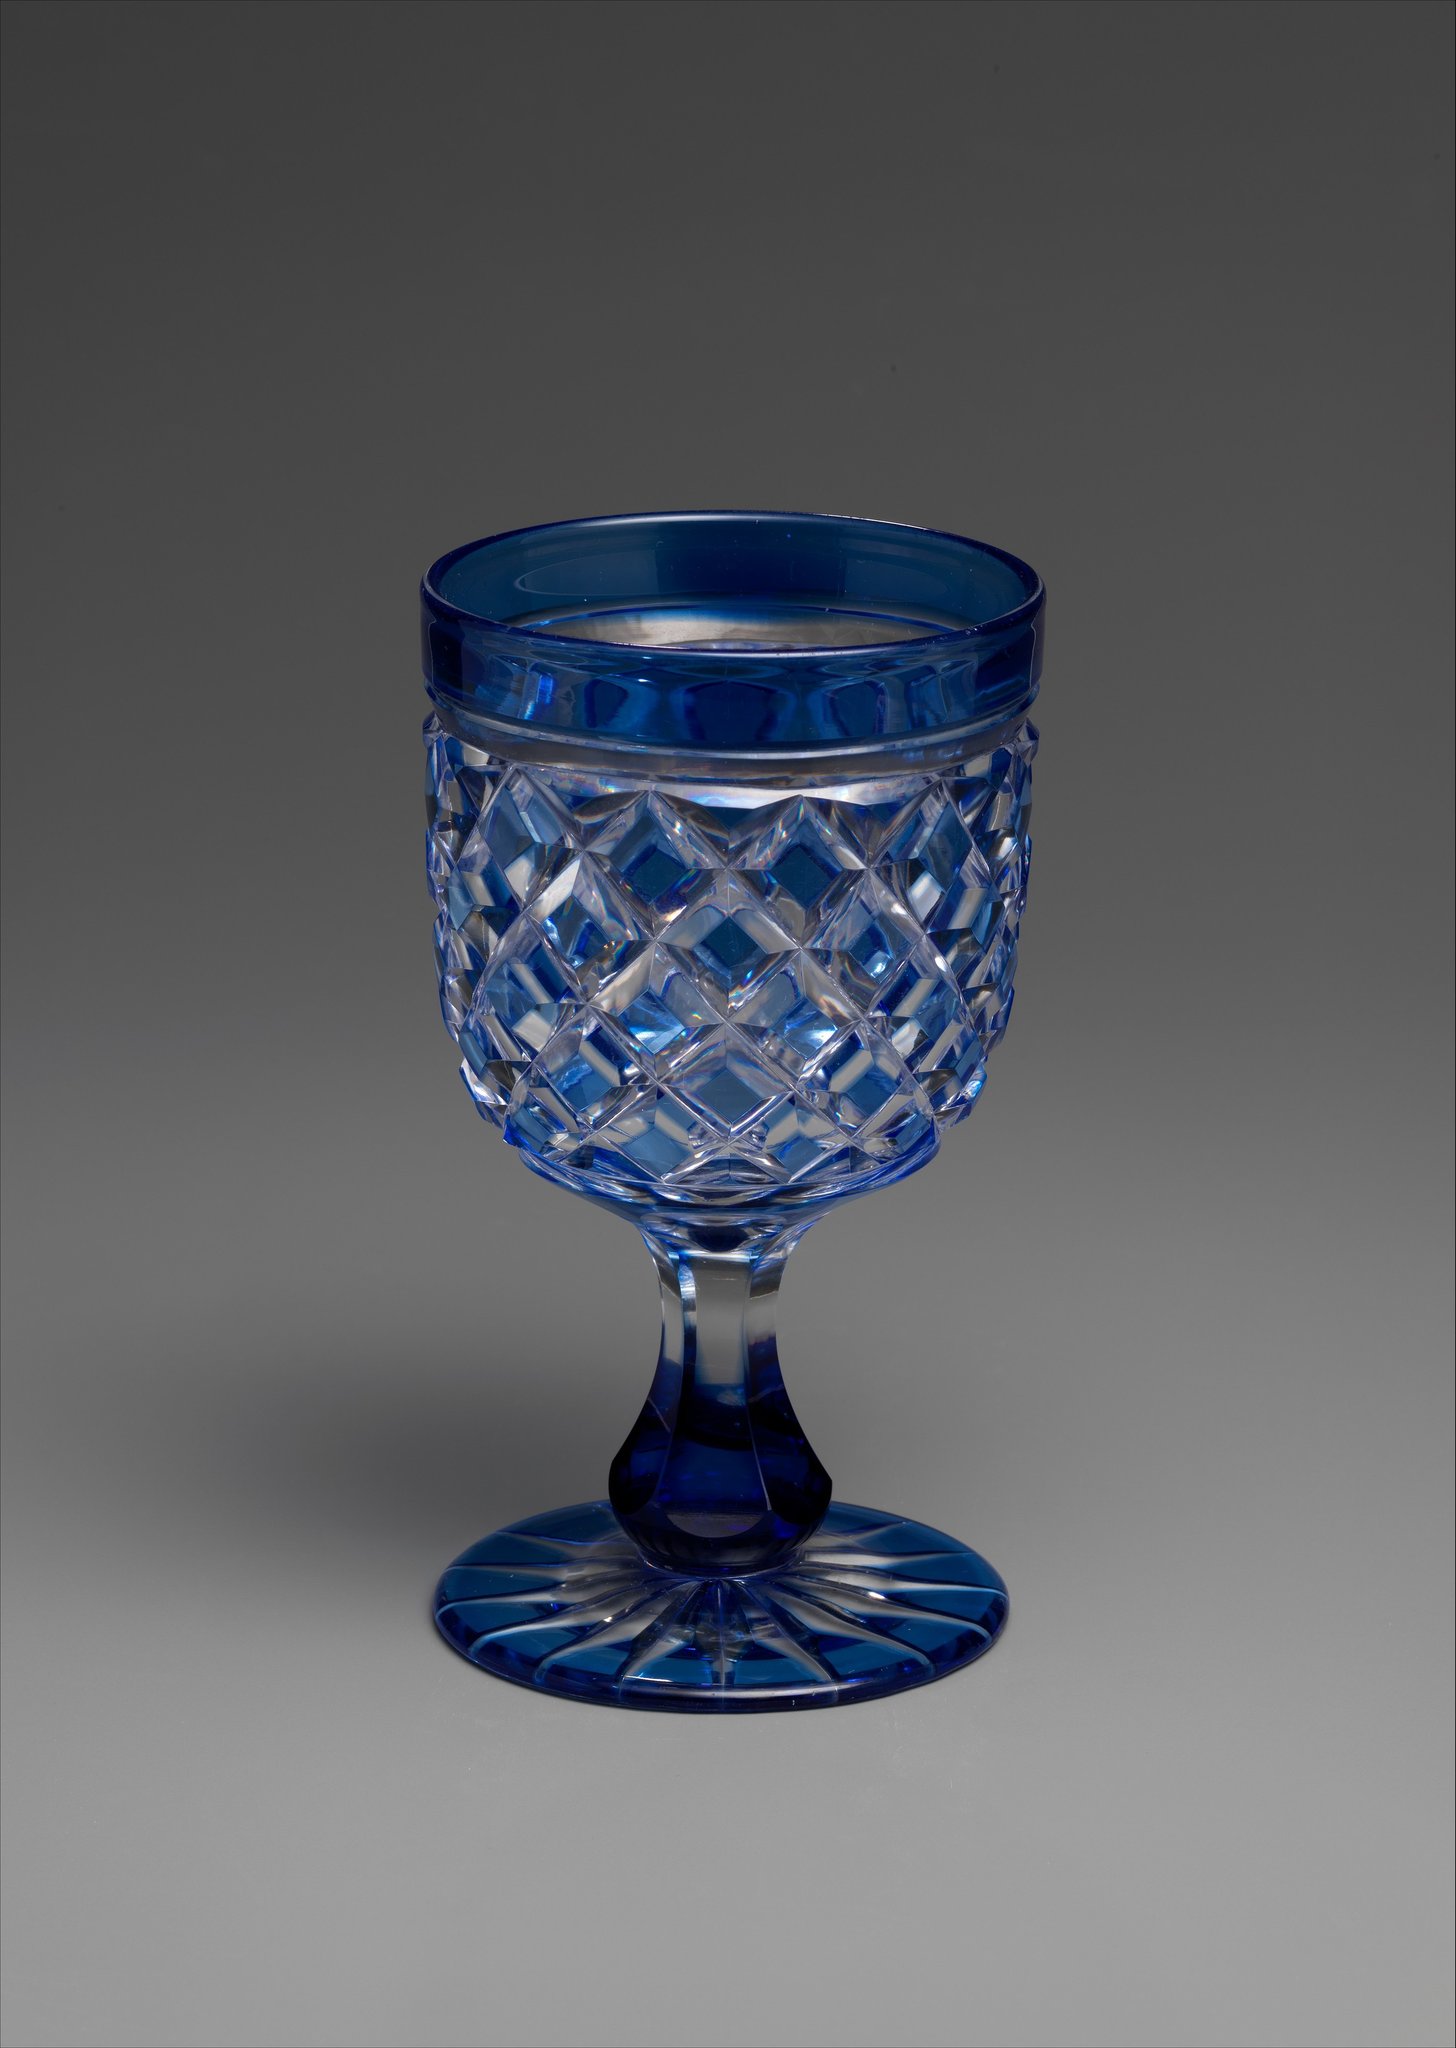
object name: goblet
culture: american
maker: brooklyn flint glass company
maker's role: manufacturer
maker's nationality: american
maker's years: 1824-1868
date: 1850-1855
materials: glass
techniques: cutting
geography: united states